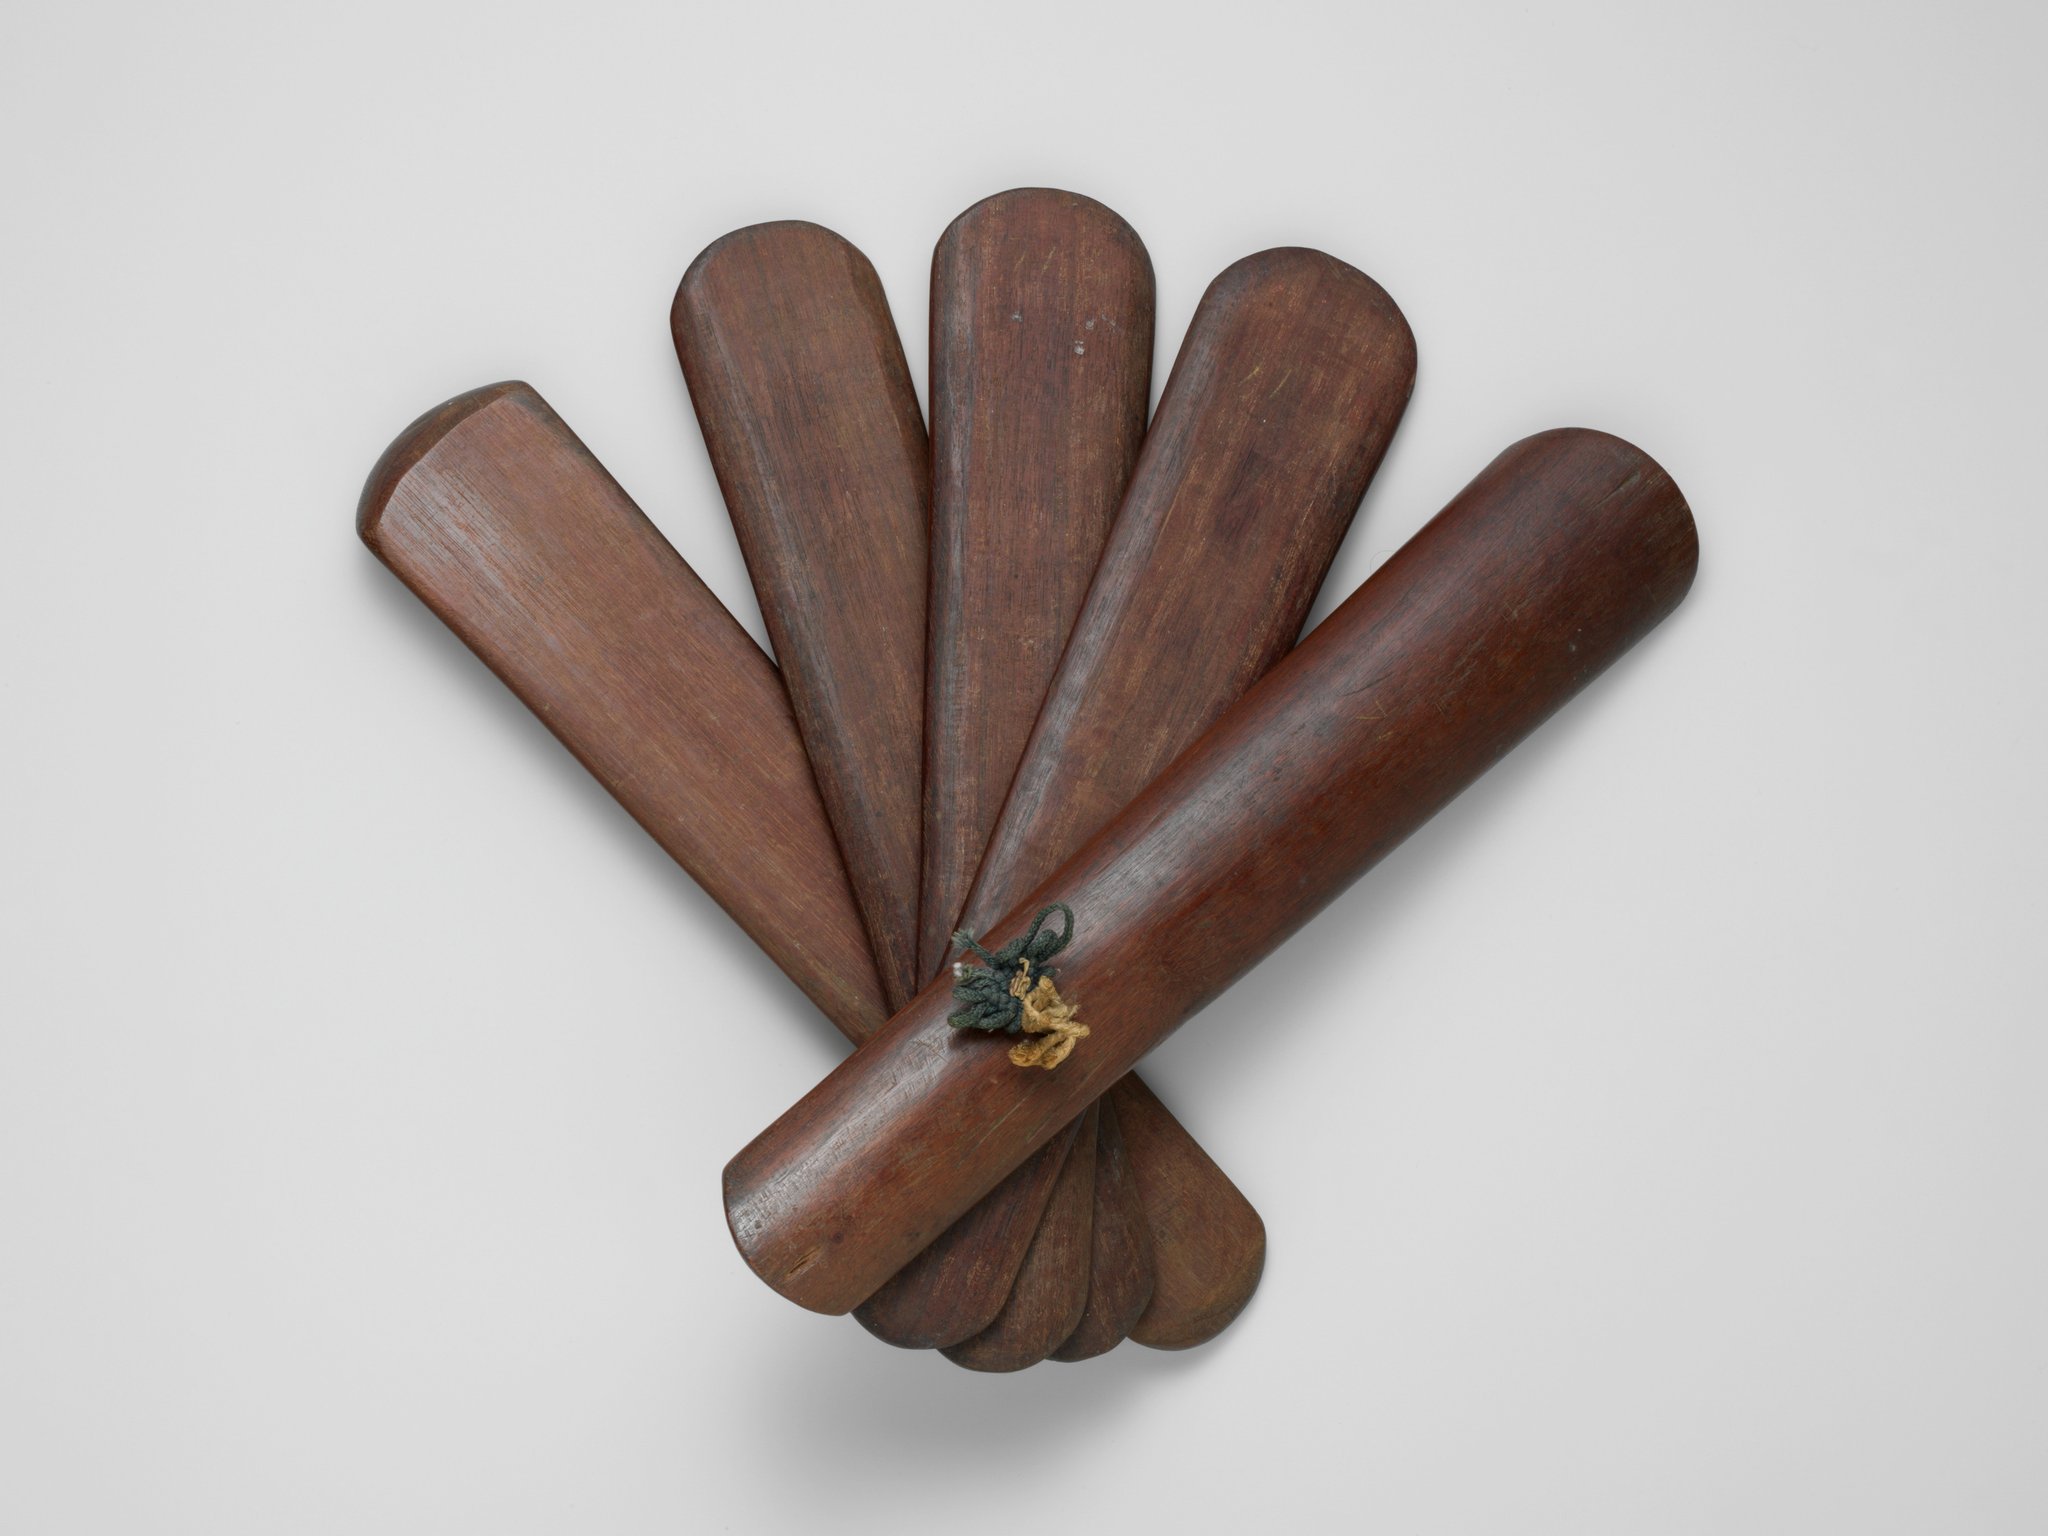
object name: bǎn clapper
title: Bǎn (板 )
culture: chinese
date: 1867-1900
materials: wood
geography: china